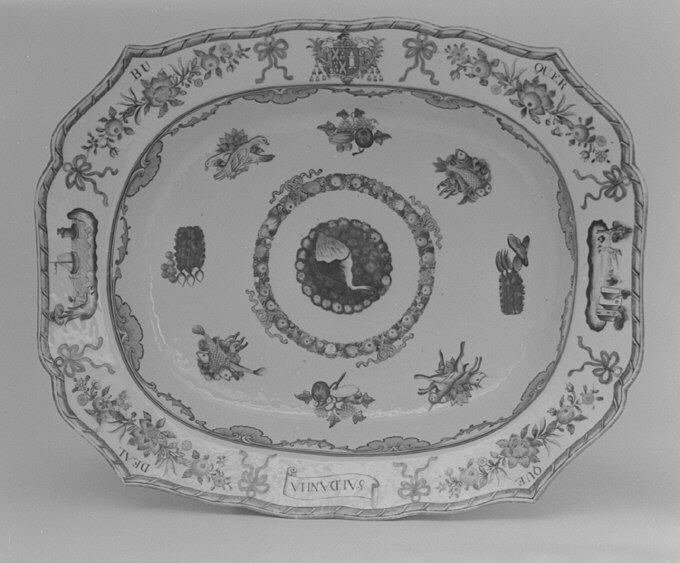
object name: platter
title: Deep platter (part of a service)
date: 1765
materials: hard paste porcelain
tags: birds,fish,coat of arms